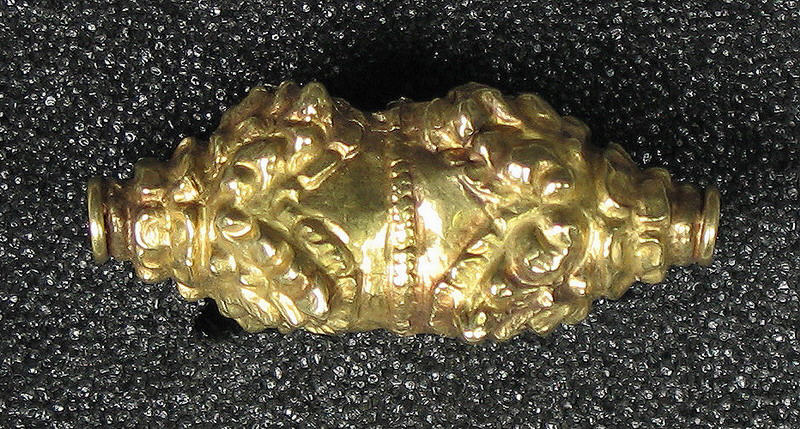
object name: pendant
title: Ornate Upper Roof Pendant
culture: indonesian, central java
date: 701-1200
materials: gold